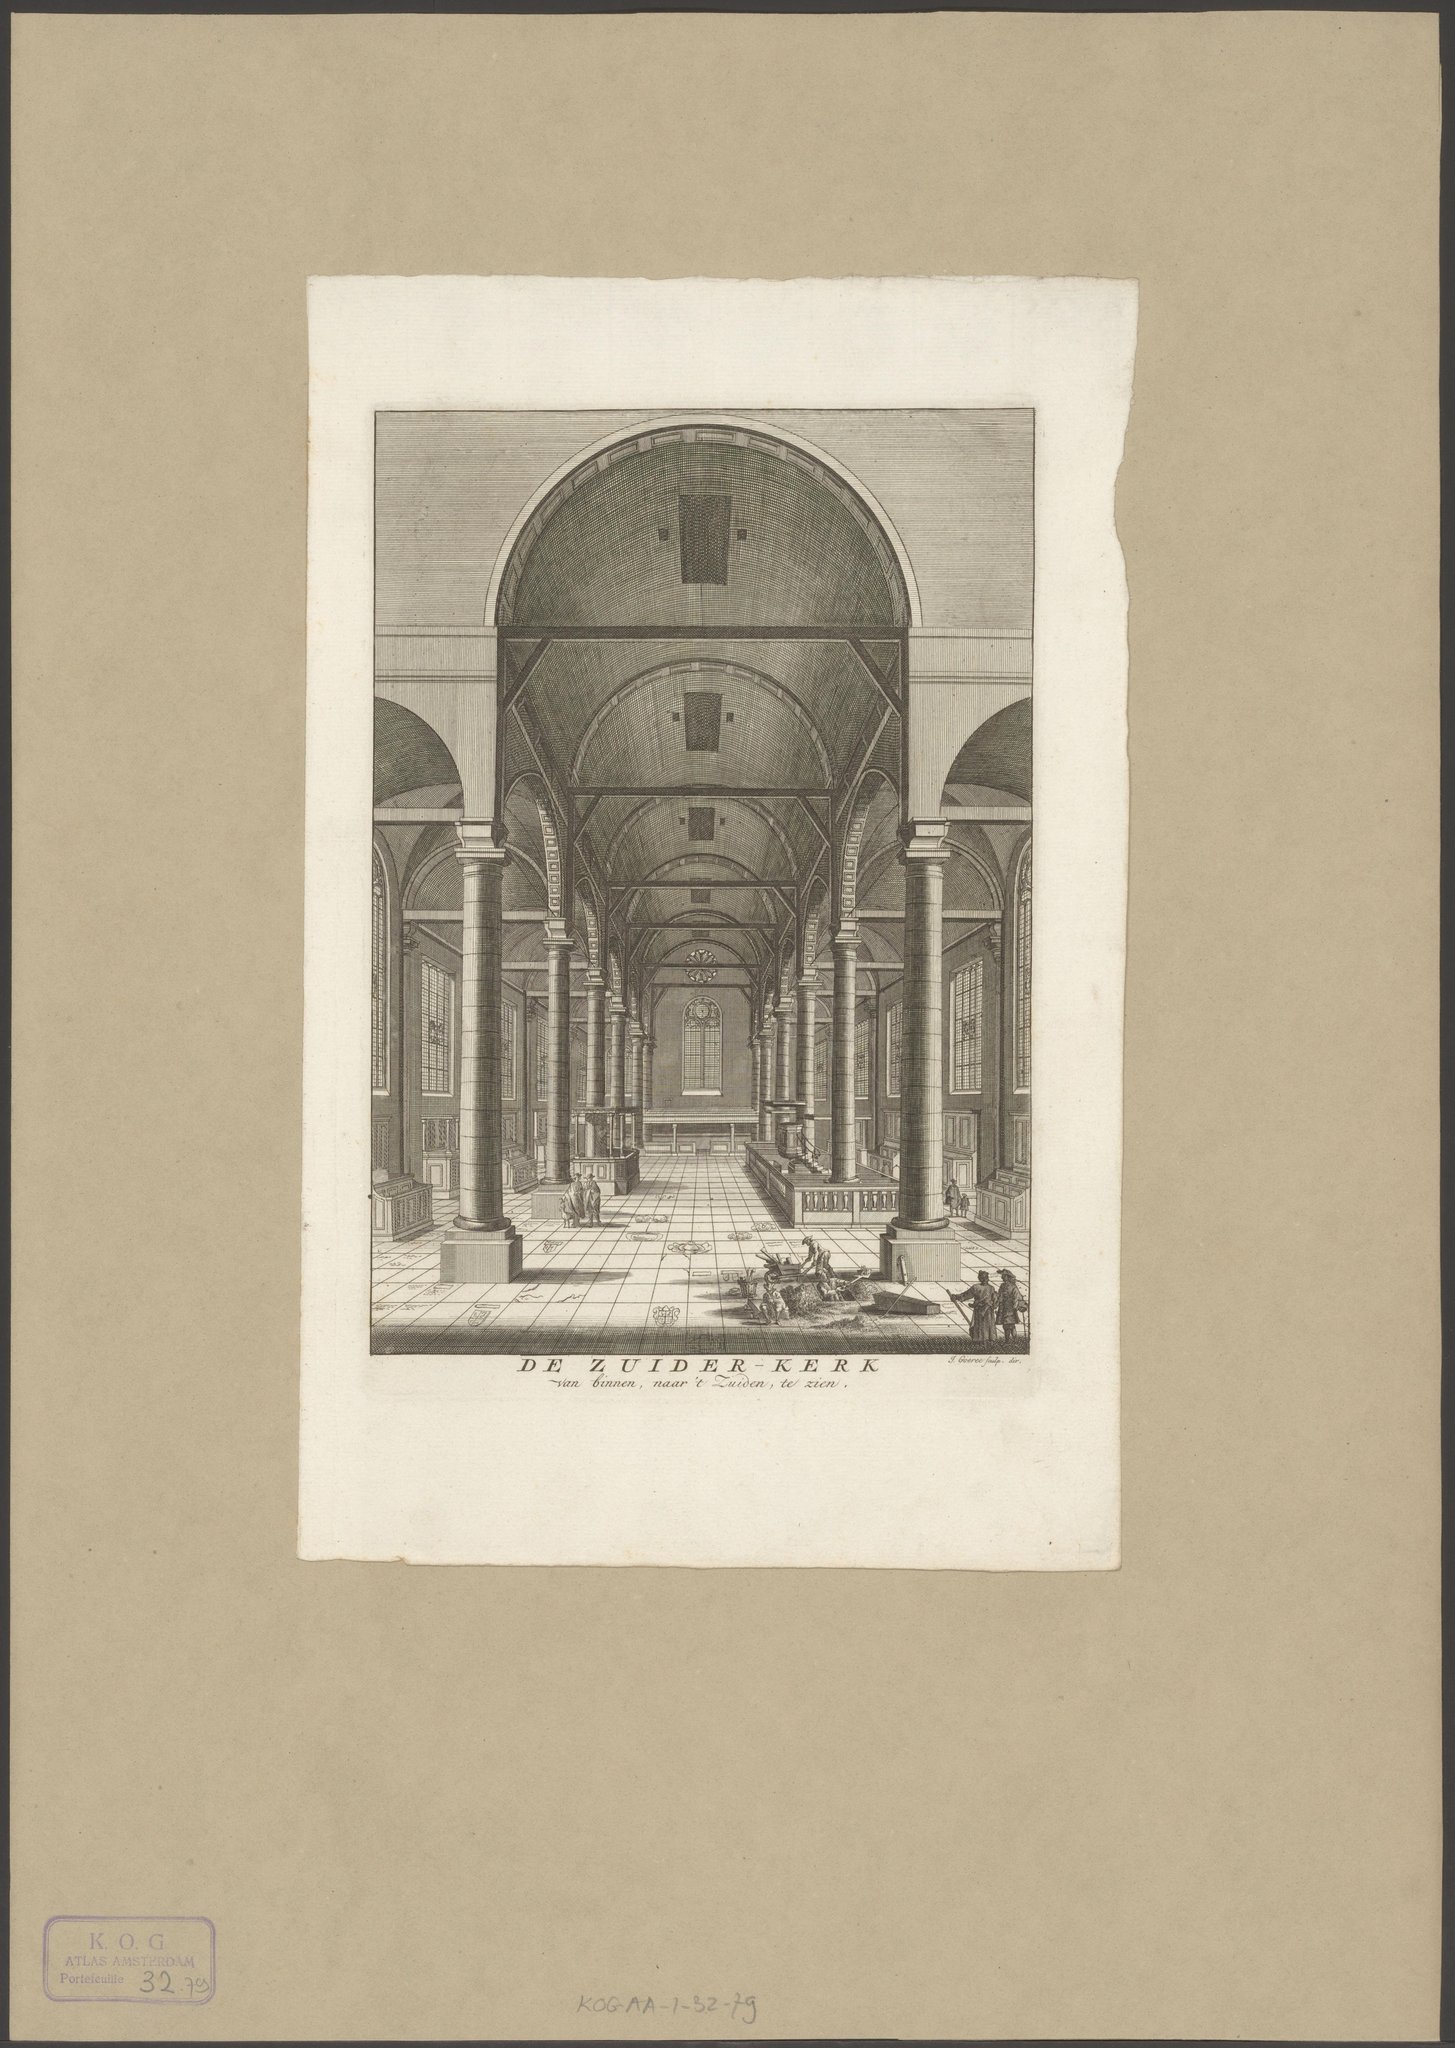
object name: print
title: De Zuider-Kerk van binnen, naar 't Zuiden, te zien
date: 1765-1782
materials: paper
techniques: engraving, etching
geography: amsterdam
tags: interior of church, grave digger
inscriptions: collector's mark: Lugt 1641b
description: Prent mogelijk uit: Wagenaar, Jan. Amsterdam, in zyne opkomst, aanwas, geschiedenissen (…). Amsterdam: Isaak Tirion, 1765, dl. 2. Of uit: Verzameling der fraaiste gezigten van Amsterdam in negen en zeventig afbeeldingen. Amsterdam en Harlingen: Petrus Conradi en Volkert van der Plaats, 1782.